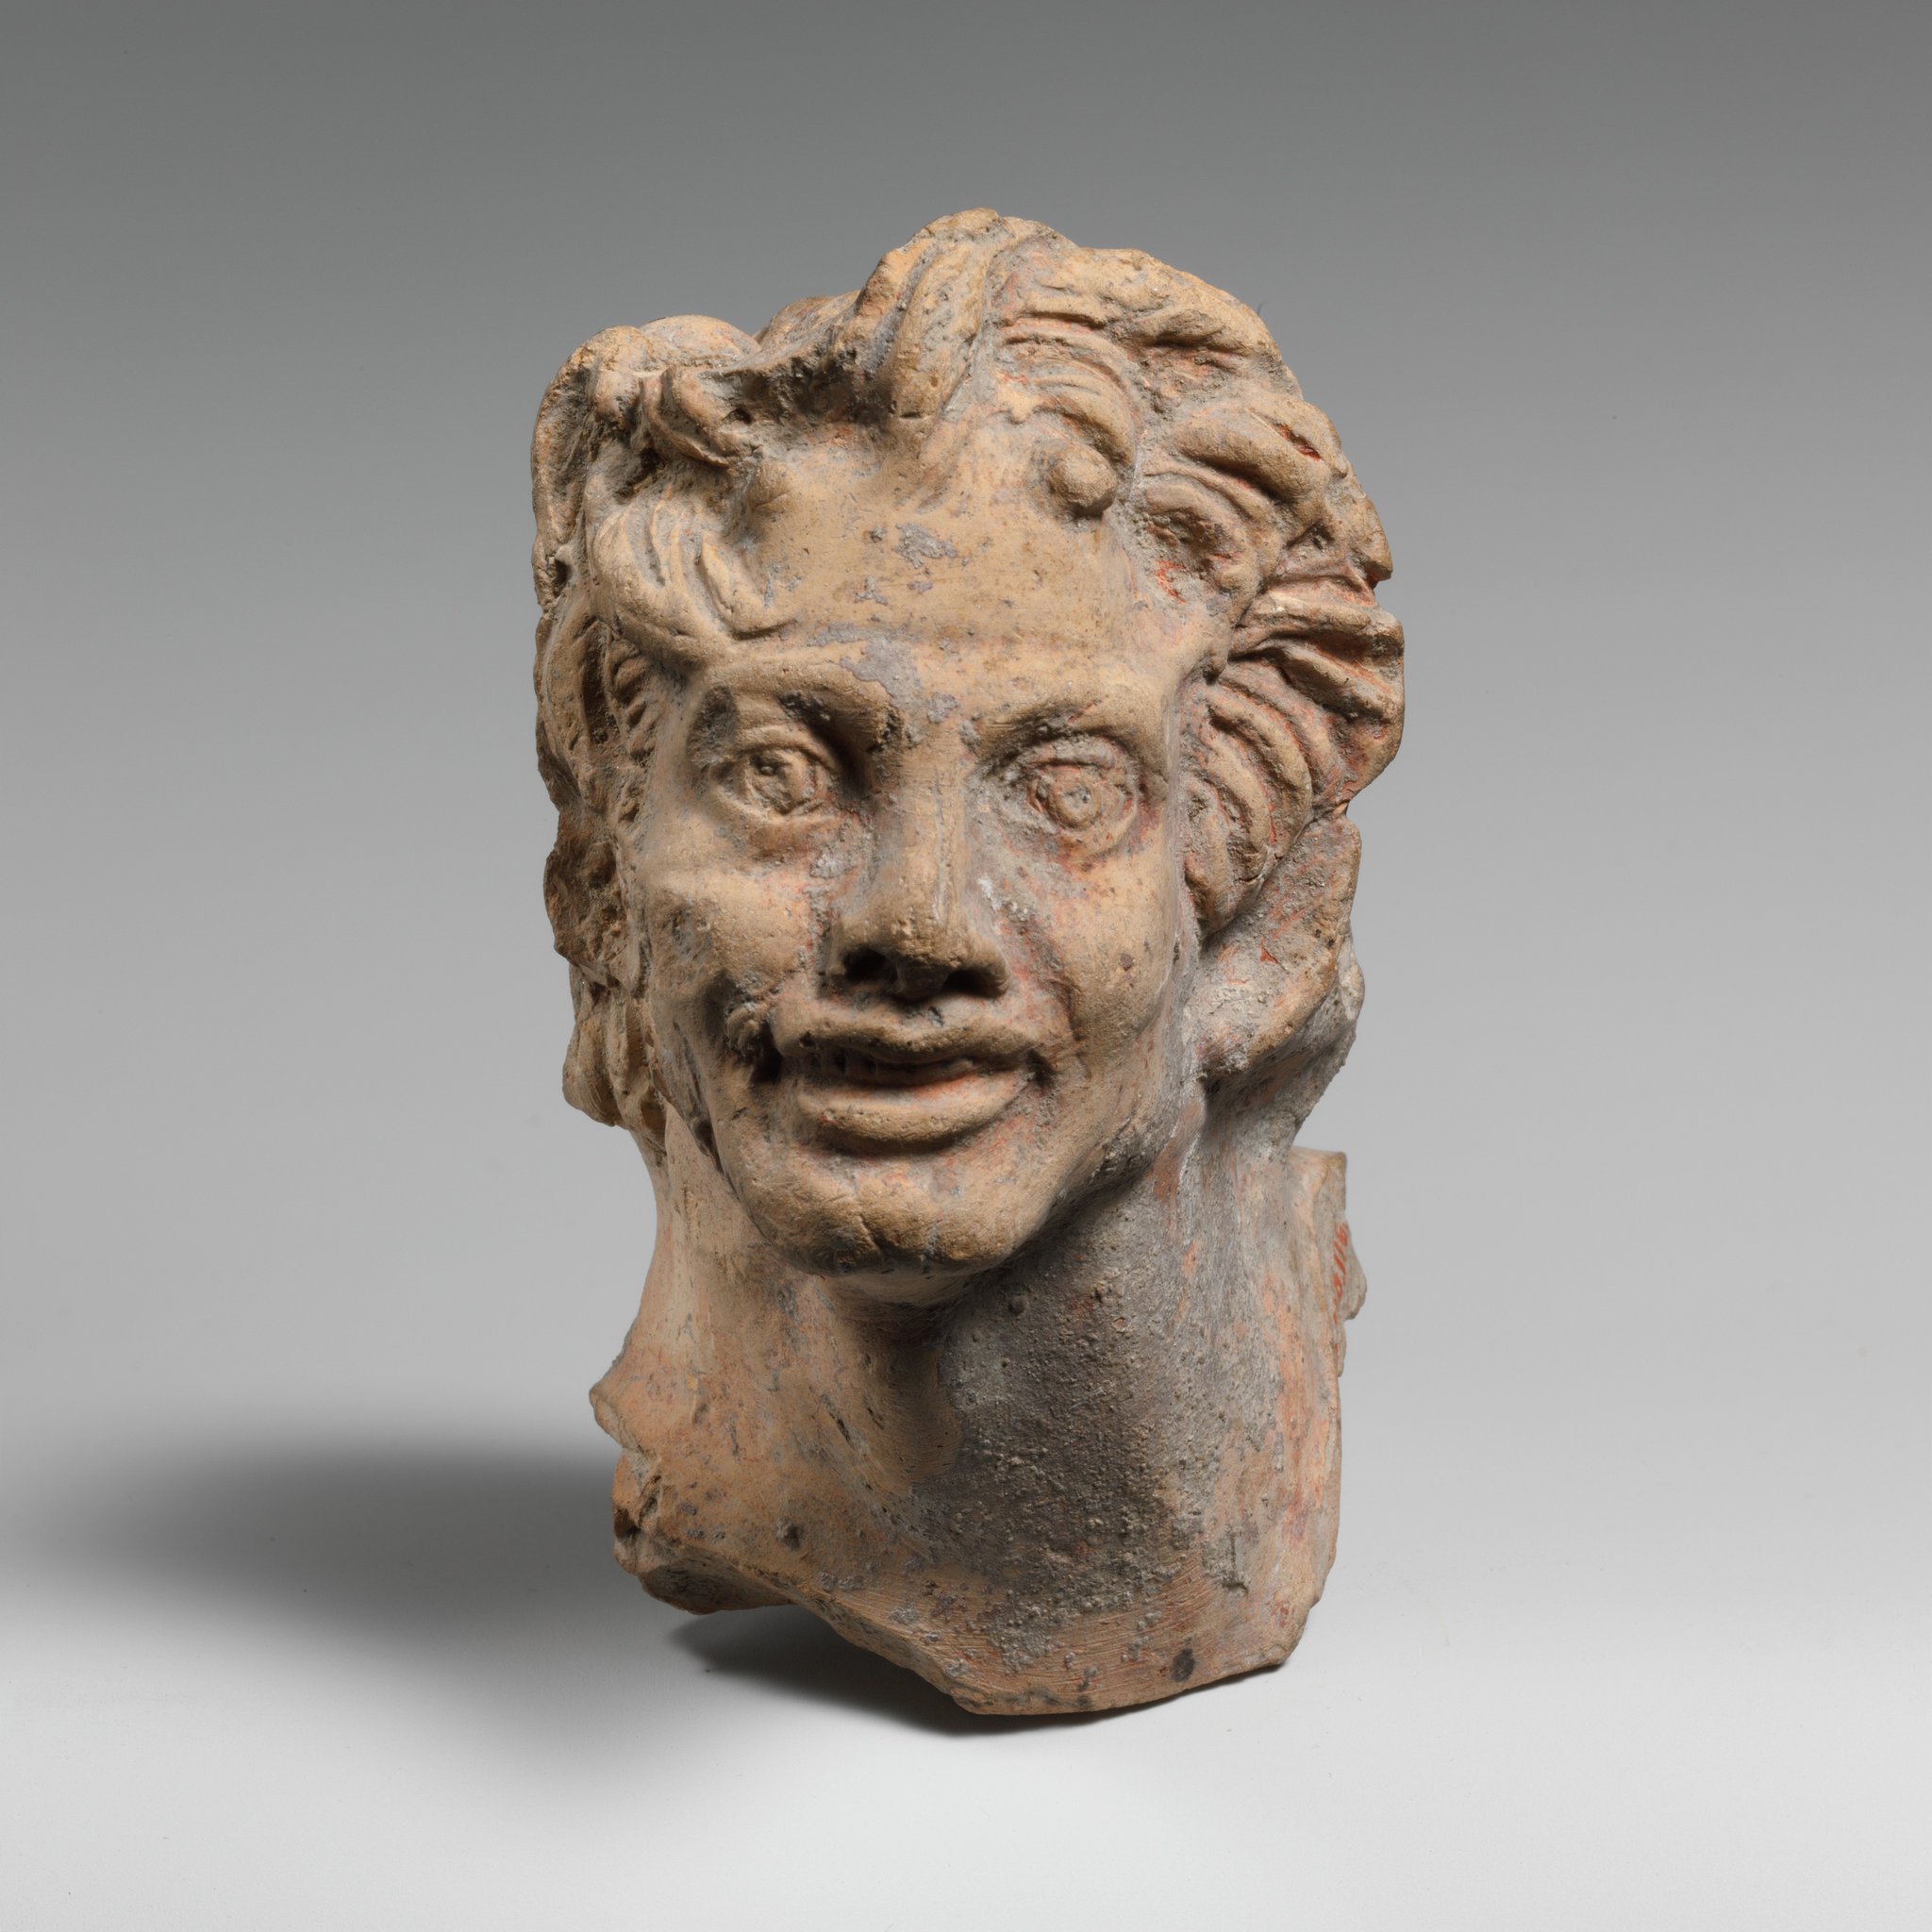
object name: head of a man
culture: greek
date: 7000-30 BCE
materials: terracotta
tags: heads,men